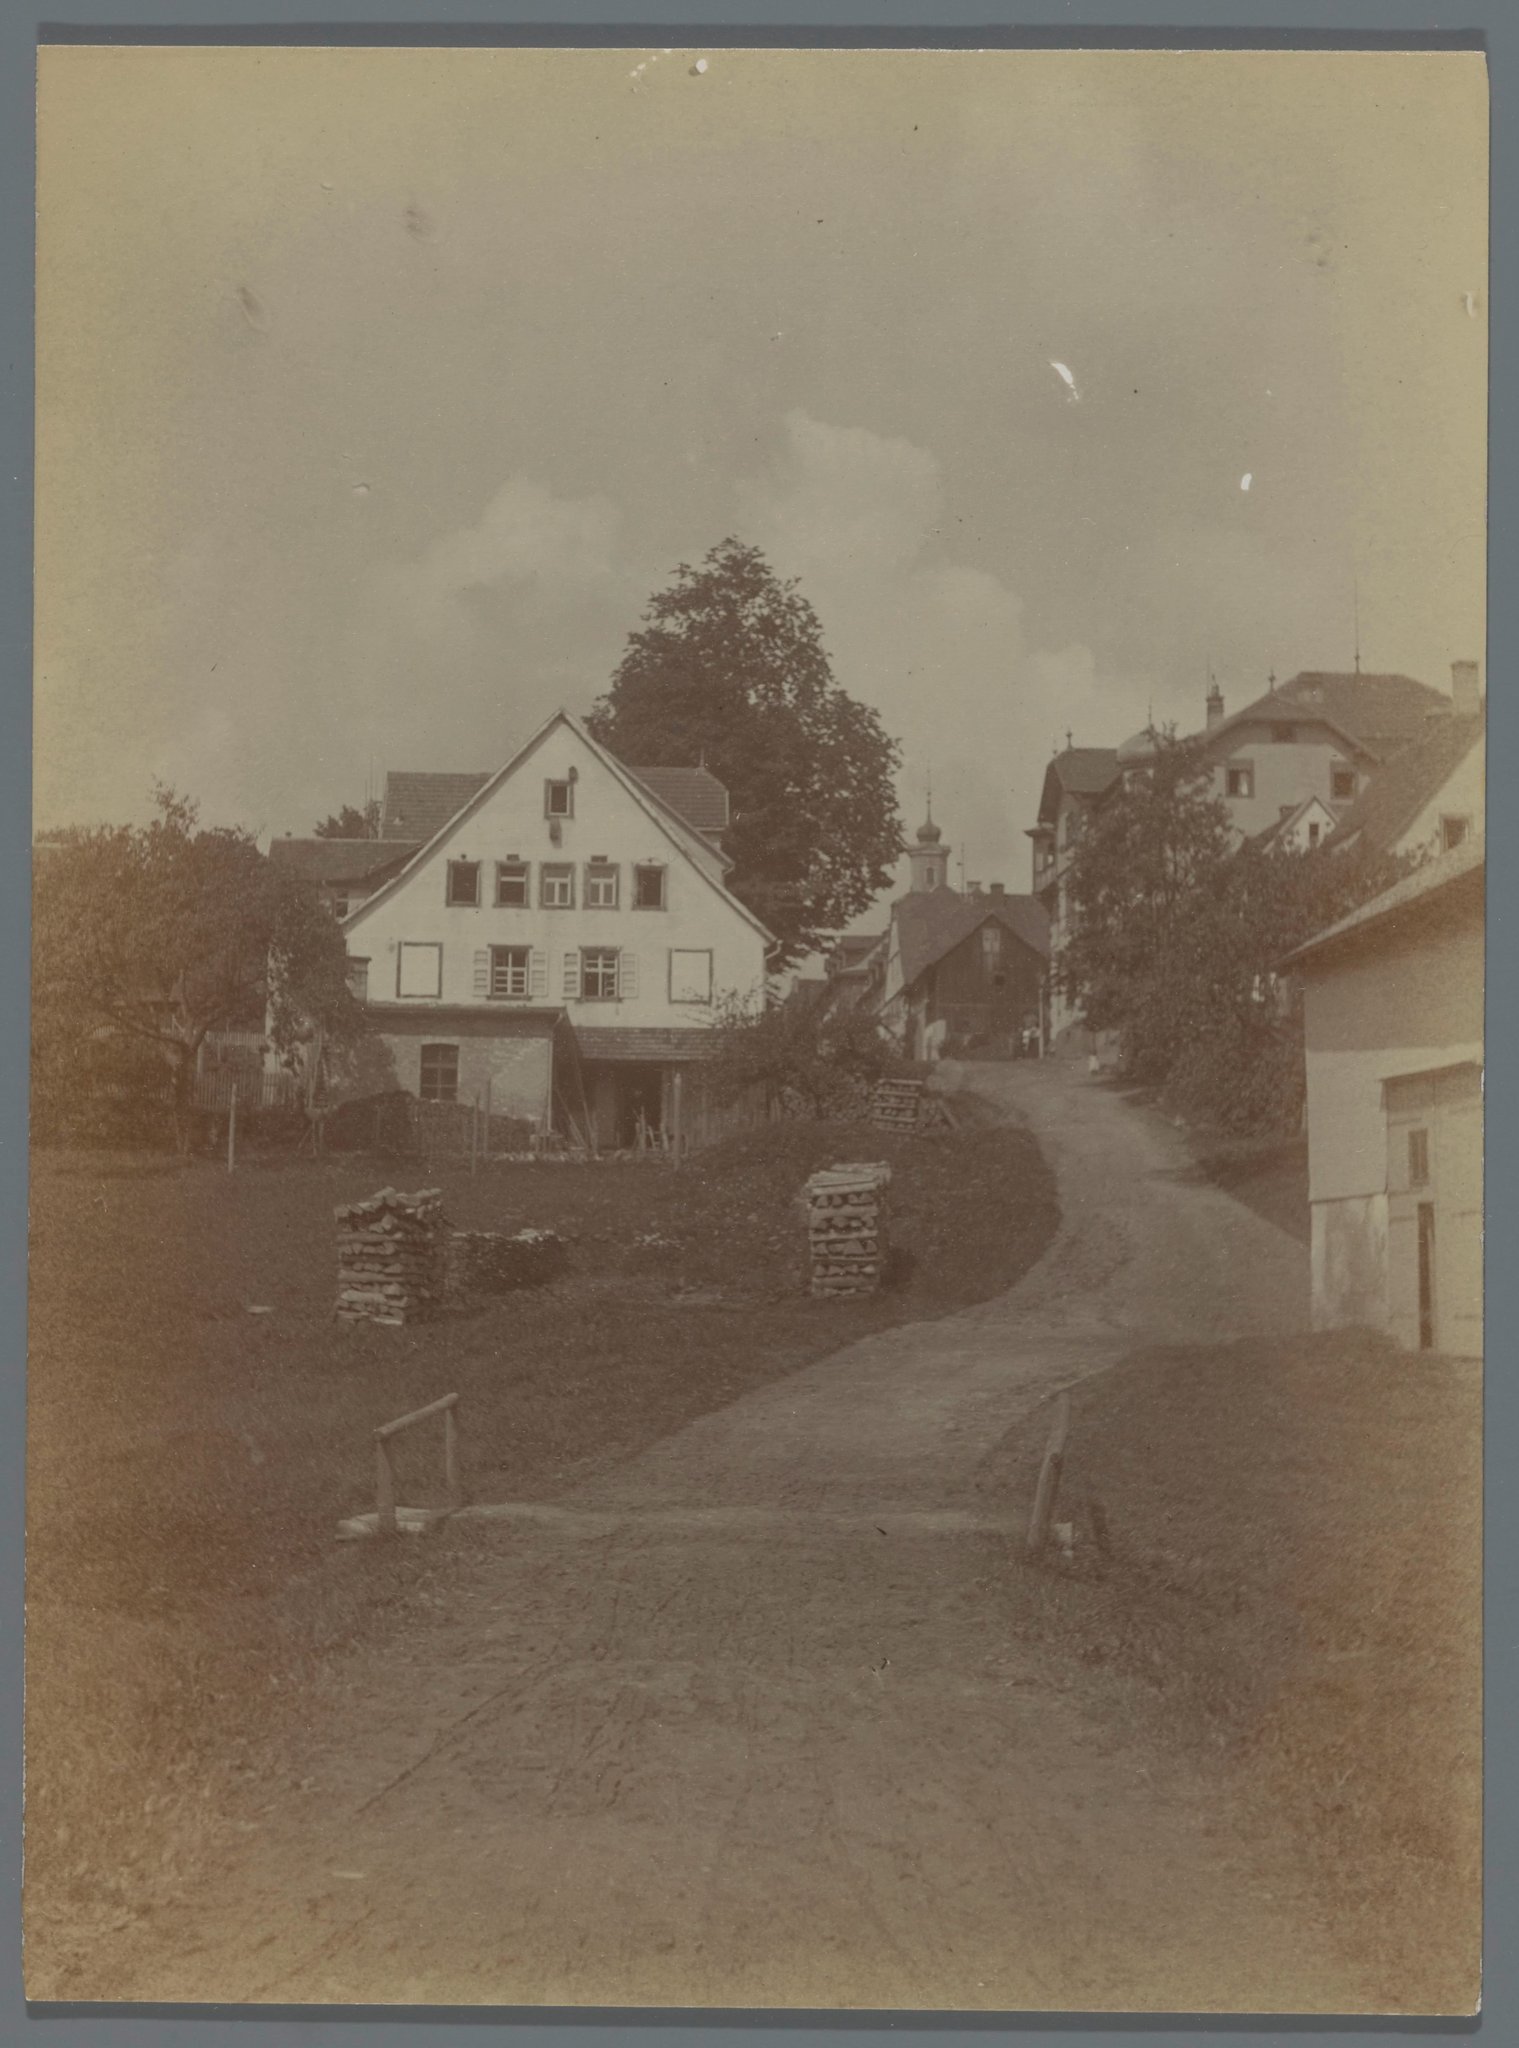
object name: photograph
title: Straatgezicht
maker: cornelia hendrika jonker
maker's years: 1874-1924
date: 1880-1940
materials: photographic support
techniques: gelatin silver print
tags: village street